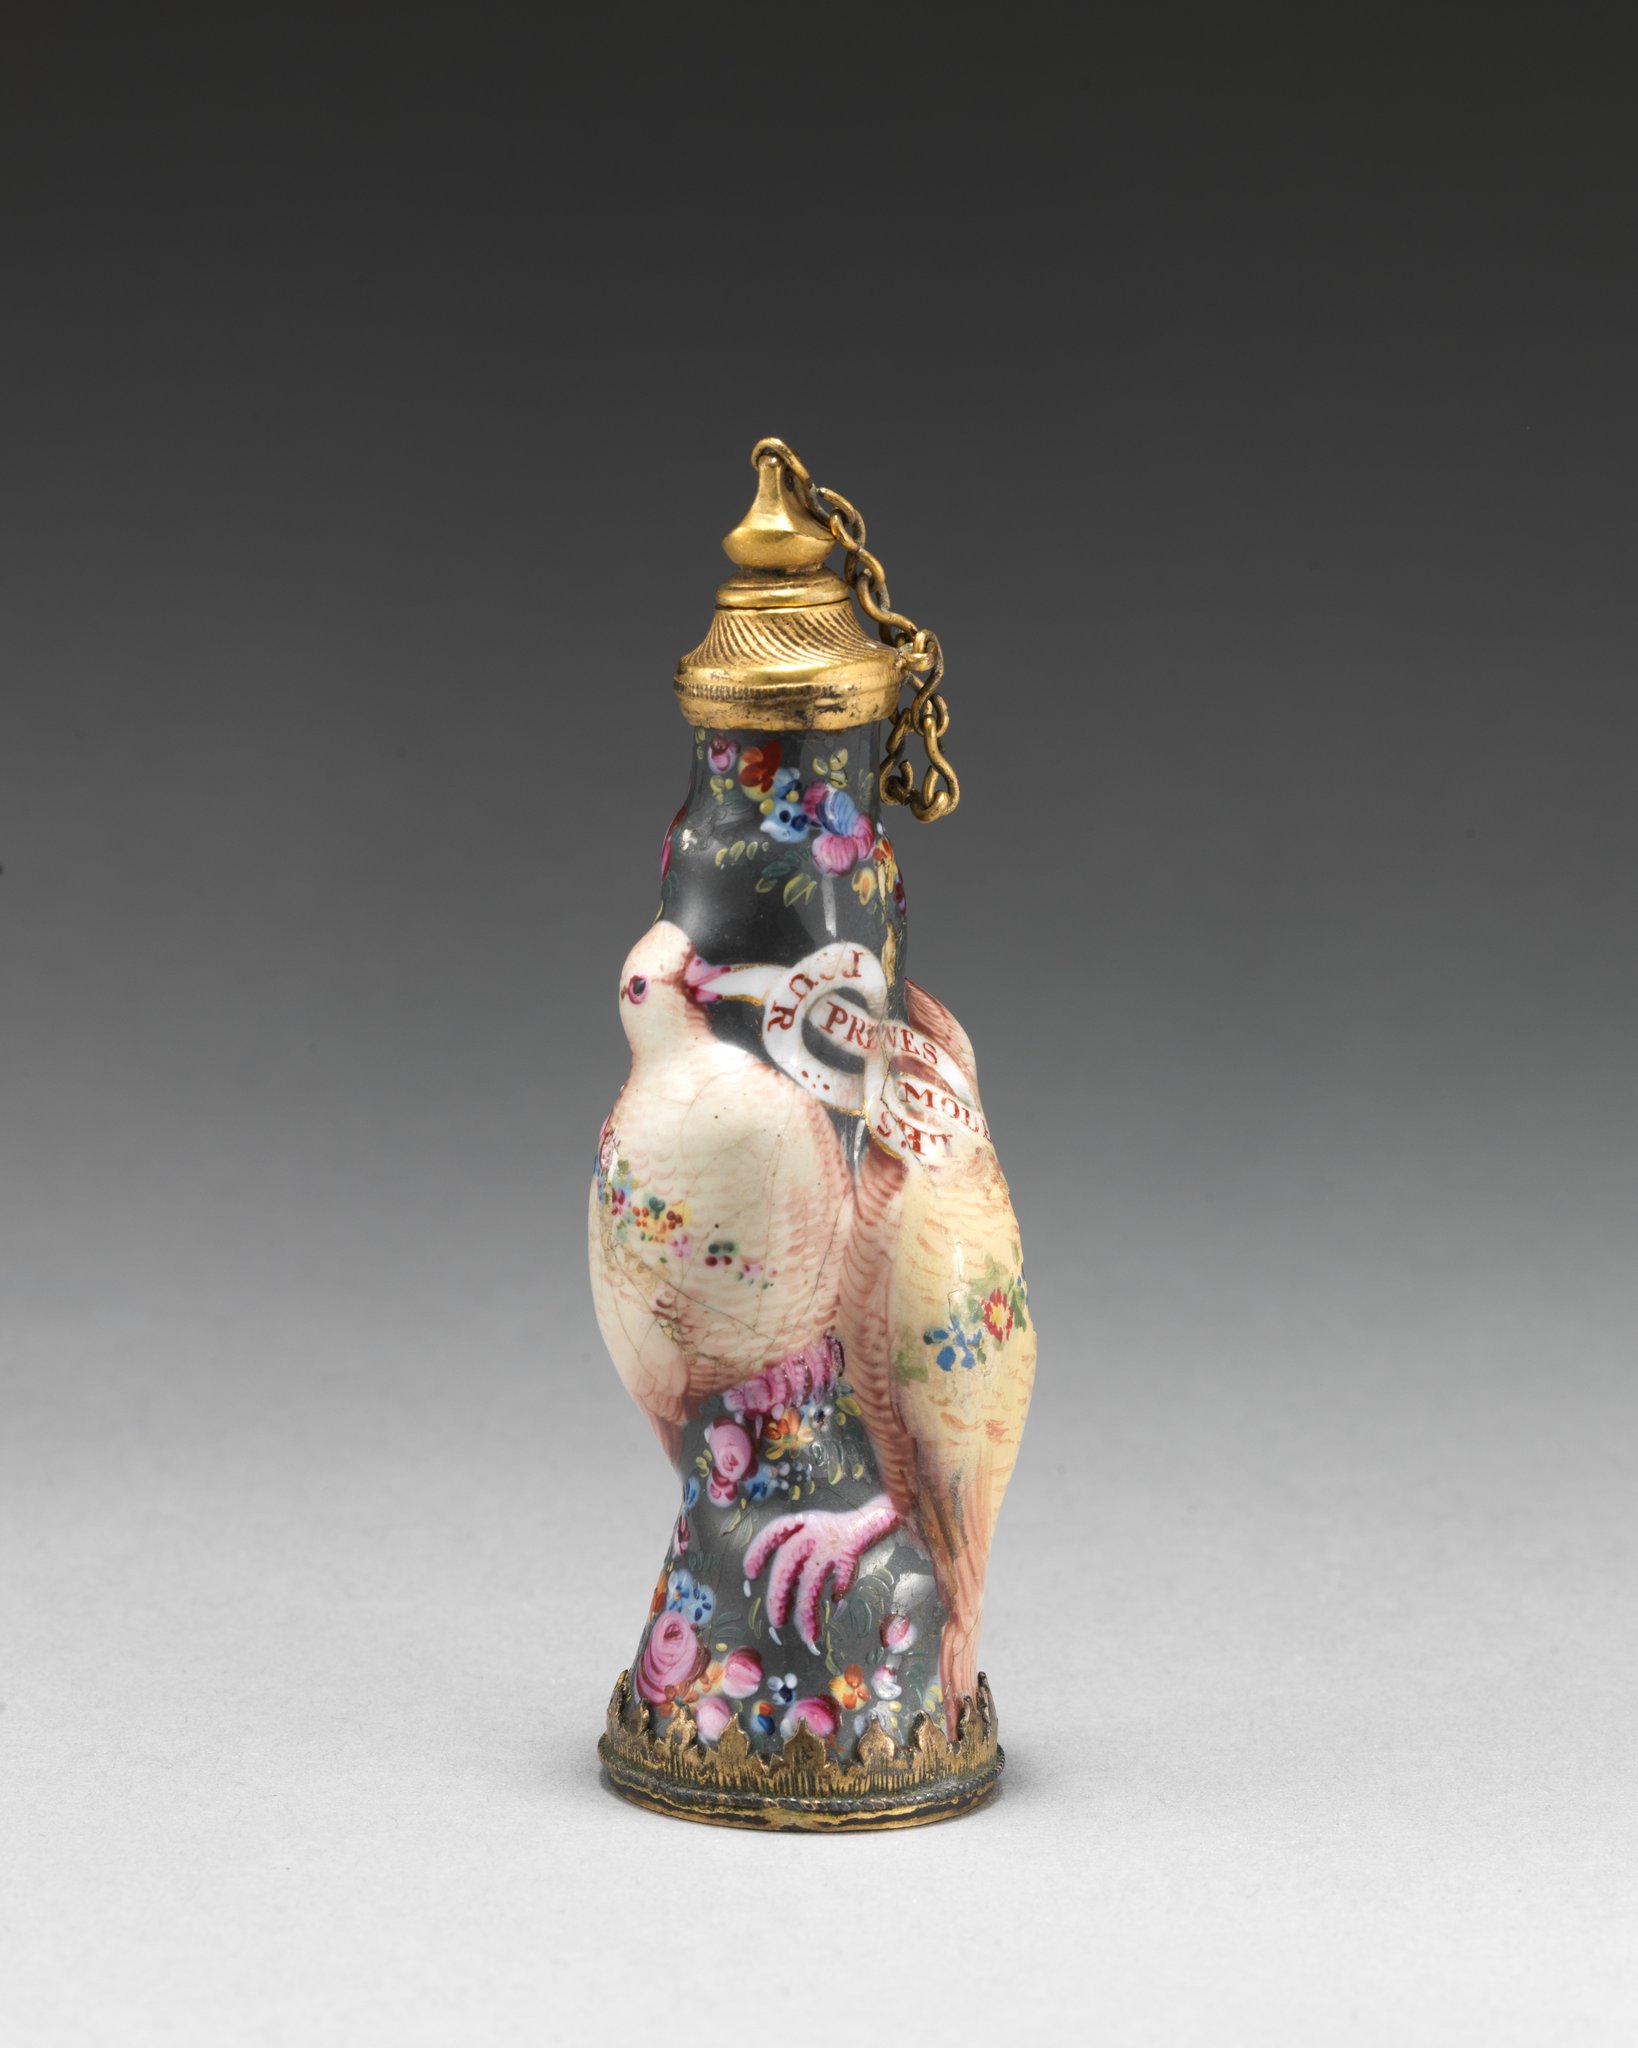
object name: scent bottle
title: Scent bottle with two doves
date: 1765-1770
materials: copper, enamel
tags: birds